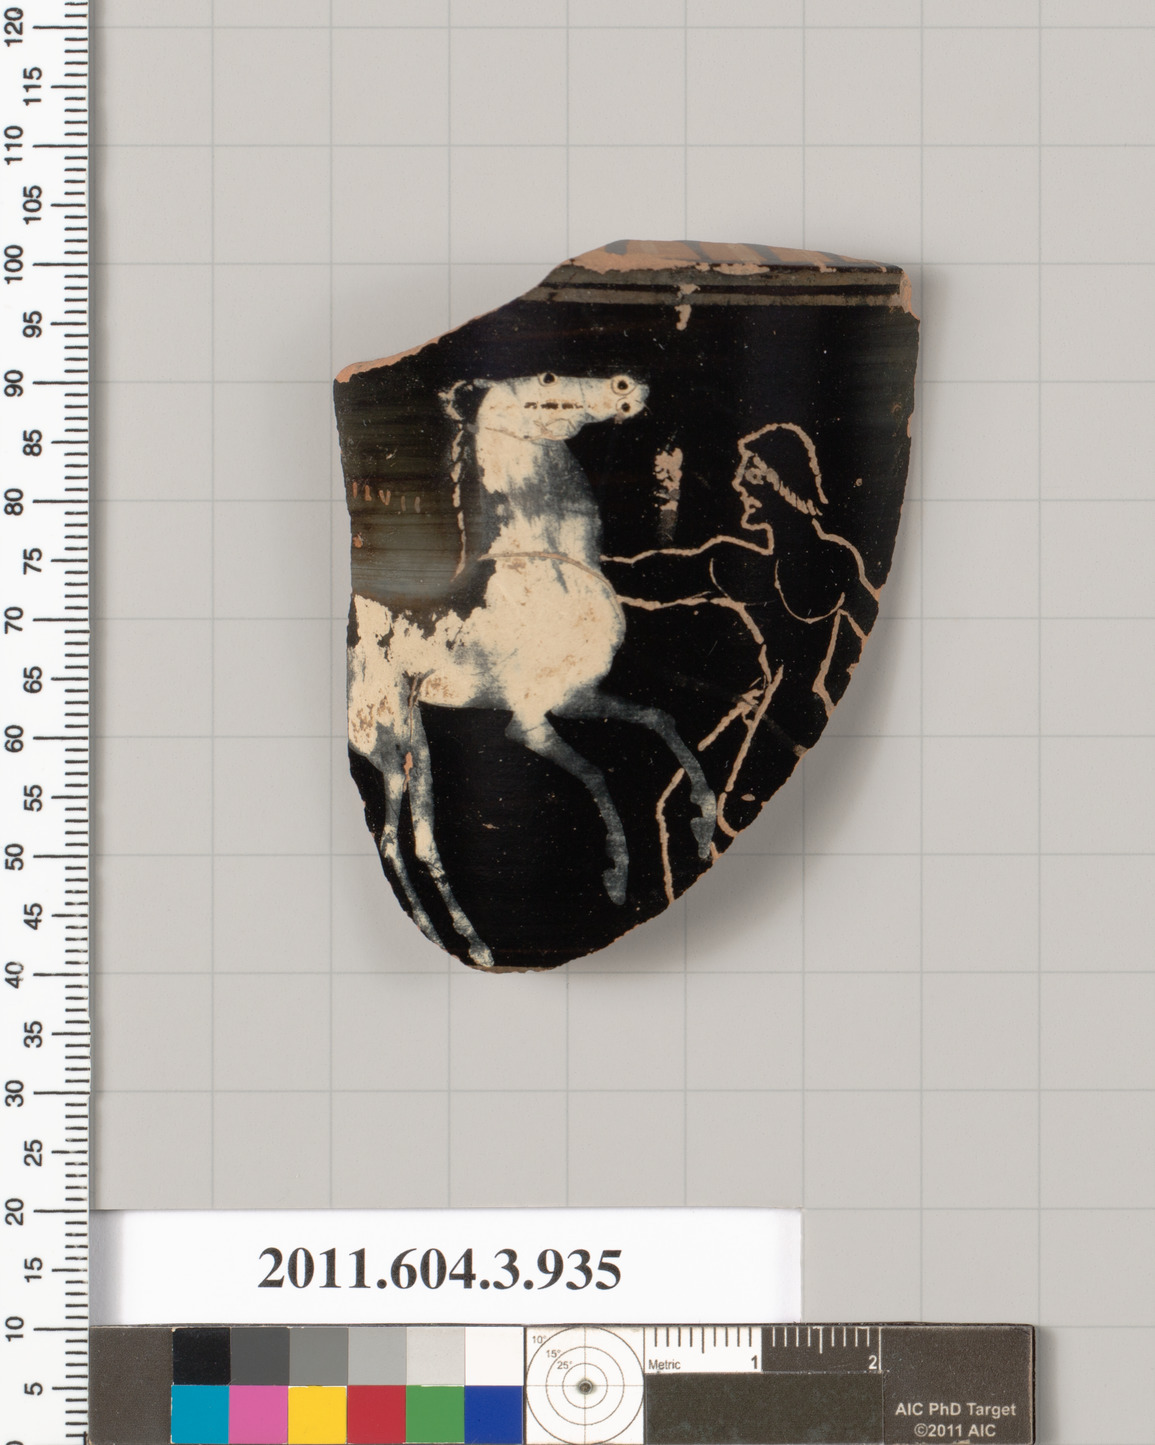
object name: lekythos fragment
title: Terracotta fragment of a lekythos (oil flask)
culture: greek, attic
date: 525-501 BCE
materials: terracotta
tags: male nudes,horses